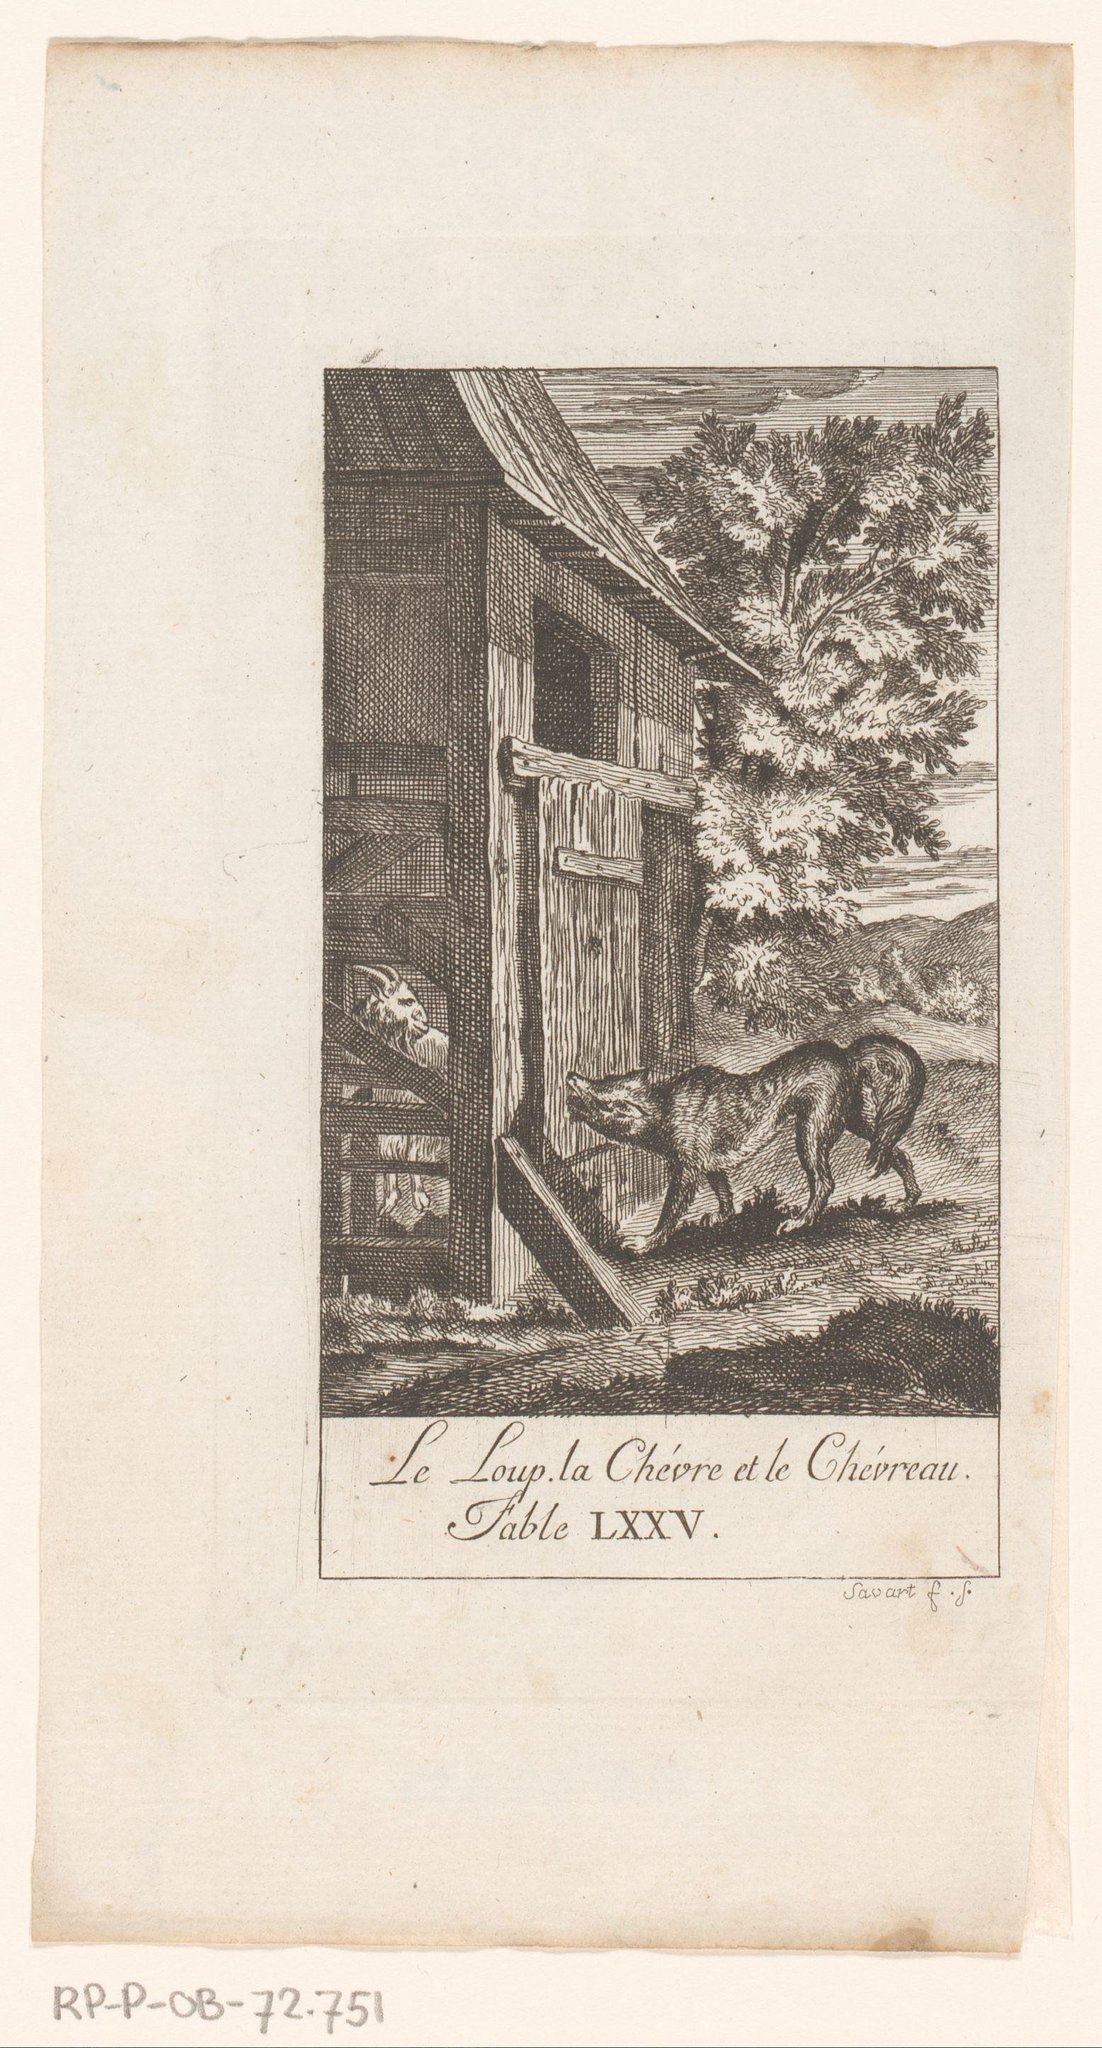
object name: print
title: Le Loup, la Chévre et le Chévreau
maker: pierre savart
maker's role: painter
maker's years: 1737-1780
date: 1747-1847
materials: paper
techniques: etching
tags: fables, goat, beasts of prey, predatory animals: wolf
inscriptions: collector's mark: Lugt 2228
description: Prent uit: La Fontaine, Jean de. Fables choisies, mises on vers. Bouillon: La Société Typographique, 1776, fabel LXXV.